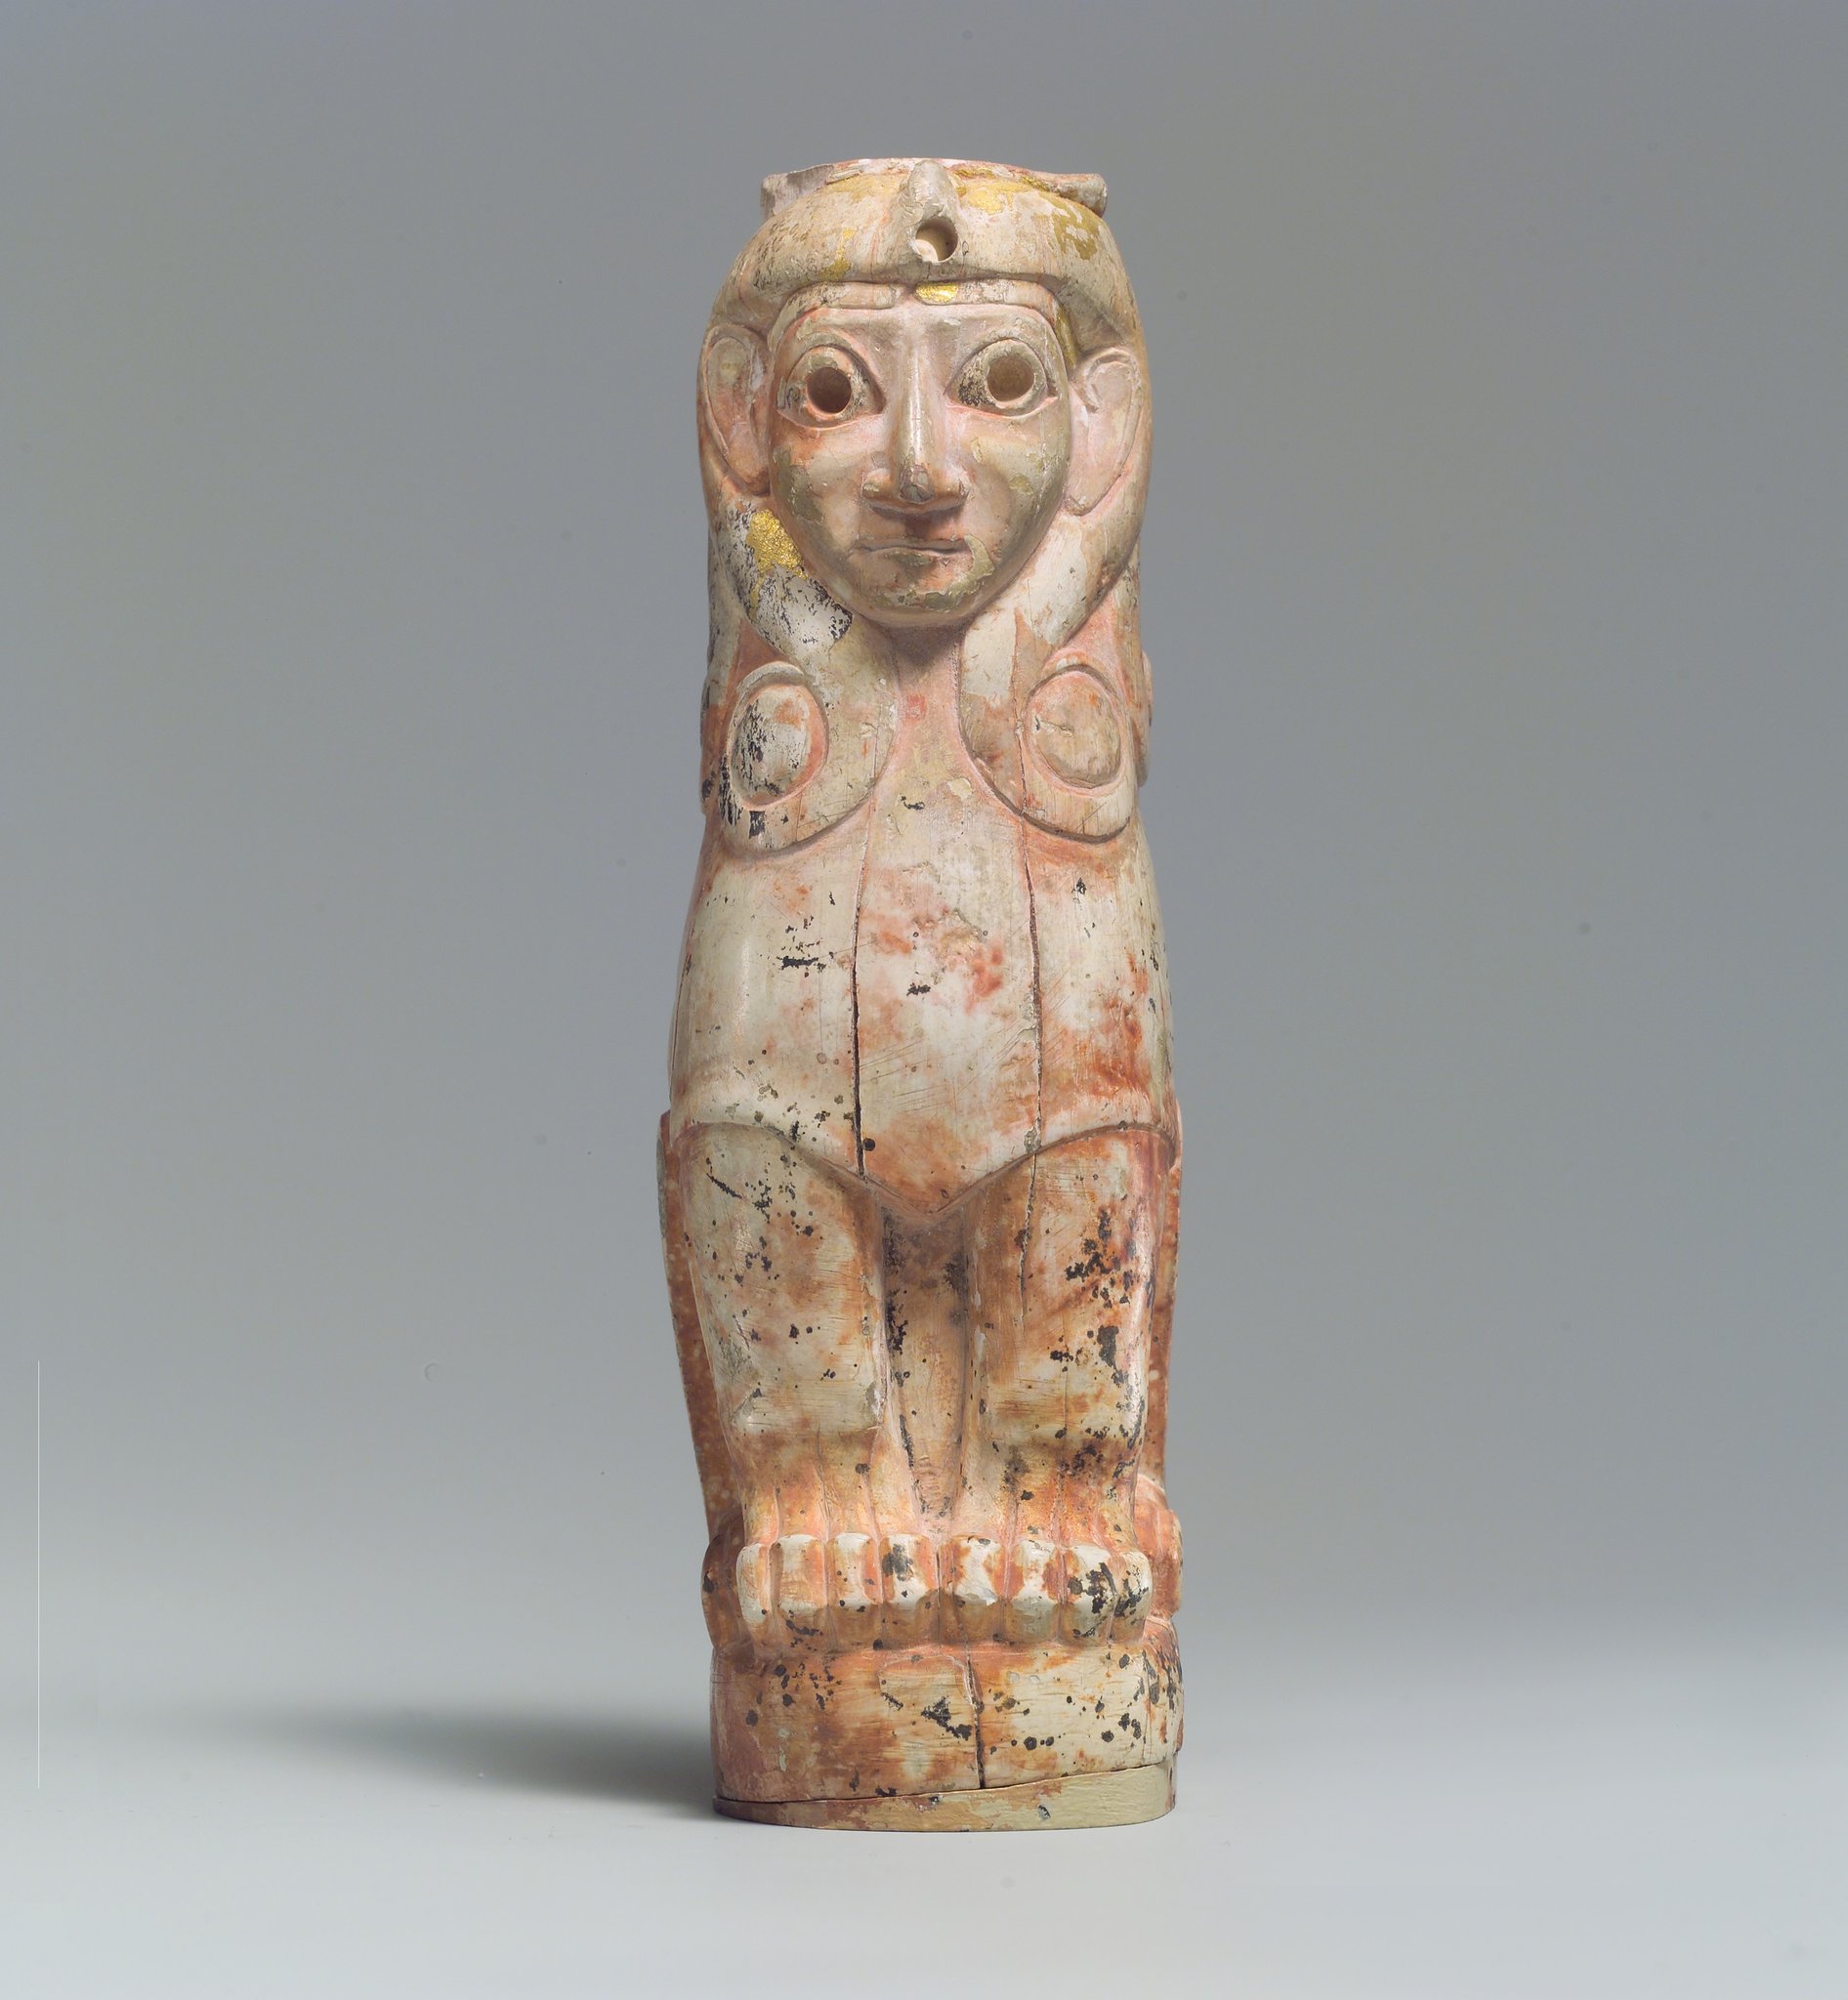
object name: furniture support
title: Furniture support: female sphinx with Hathor-style curls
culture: assyrian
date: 1800-1701 BCE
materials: gold foil, ivory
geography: anatolia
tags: sphinx